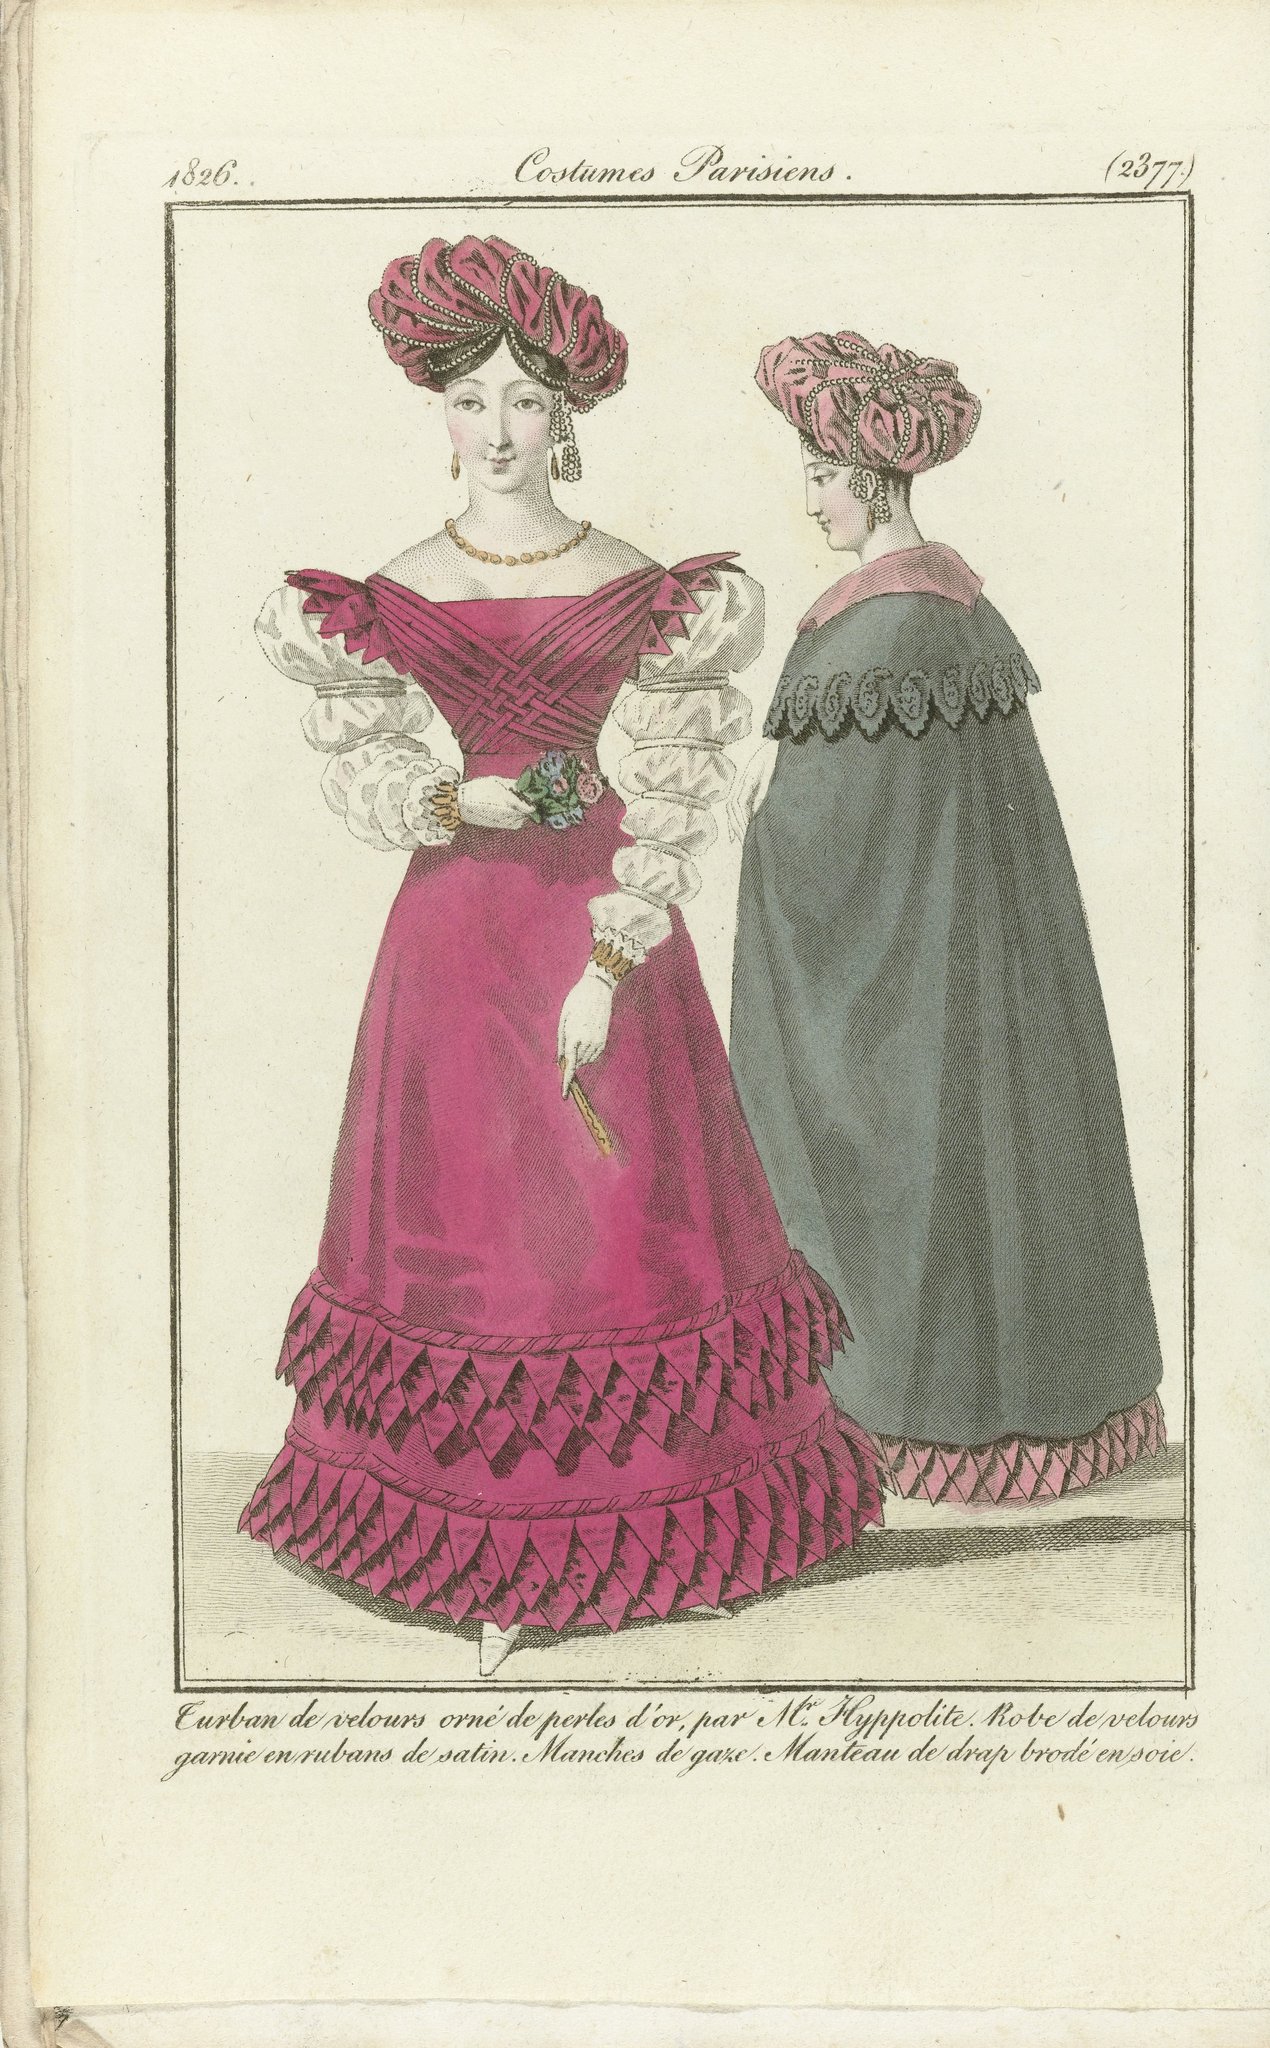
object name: fashion print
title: Journal des dames et des modes 1826, Costumes Parisiens (2377)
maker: Anonymous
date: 1826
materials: paper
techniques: etching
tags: fashion plates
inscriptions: date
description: Turban de velours orné de perles d'or, par Mr. Hyppolite. Robe de velours garnie en rubans de satin.Manches de gaze. Manteau de drap brodé en soie.